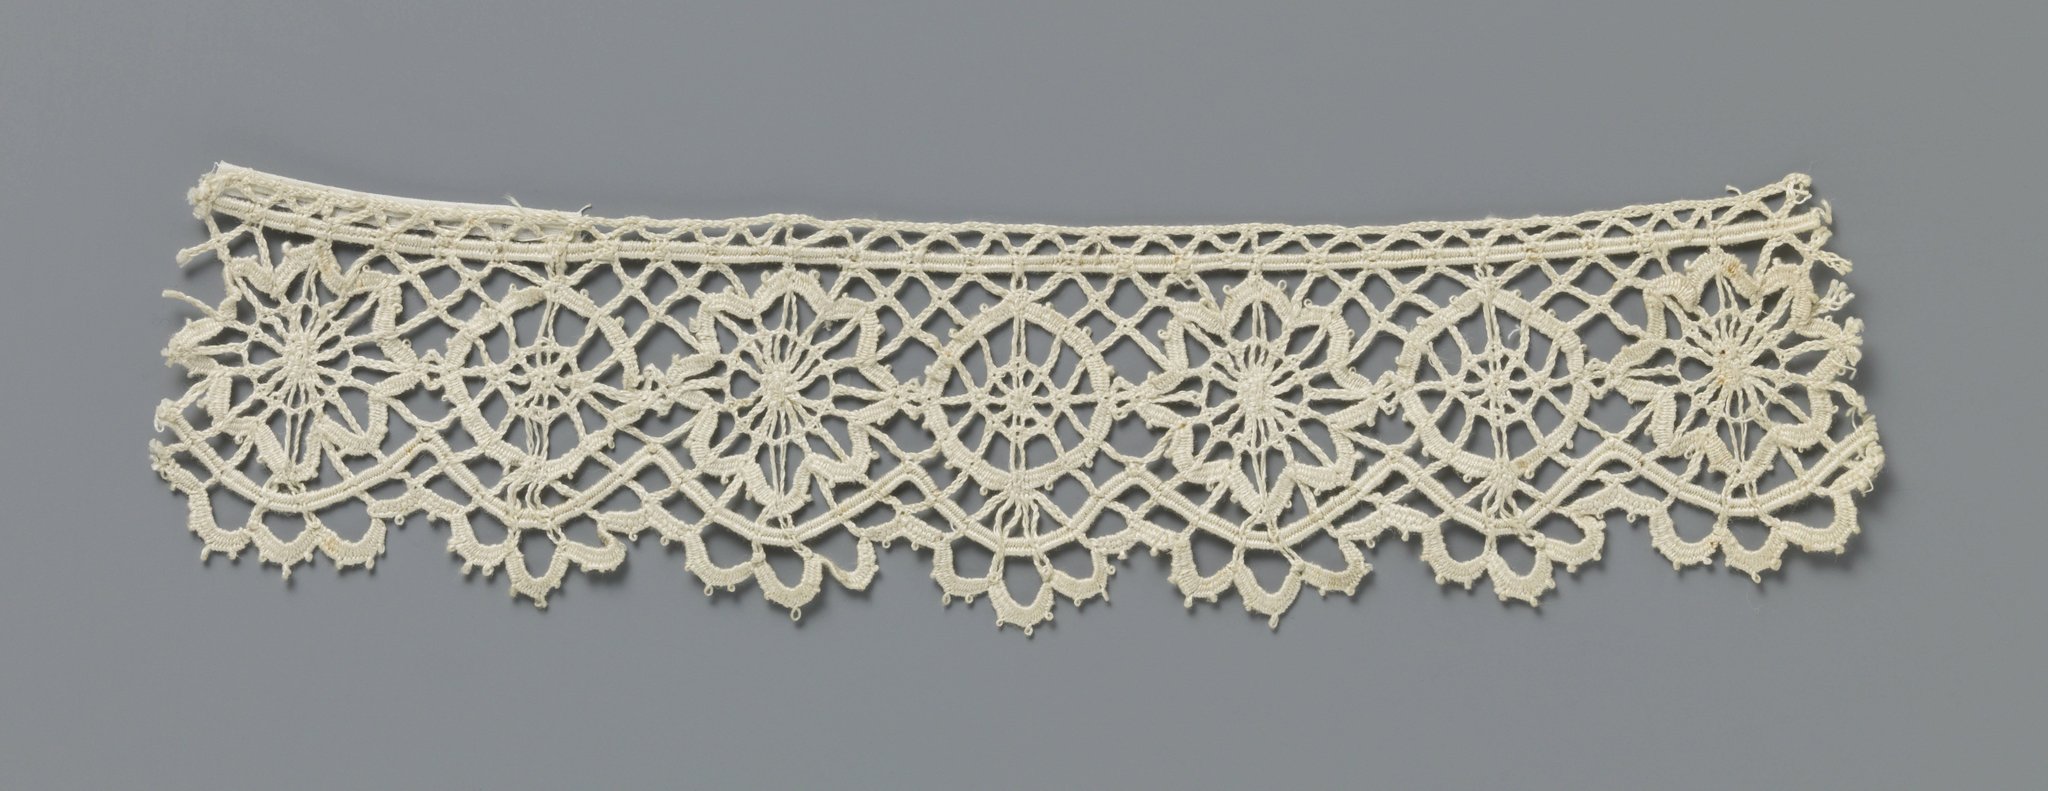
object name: strip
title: Strook kloskant met sterren en wielen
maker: Anonymous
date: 1800-1824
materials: cotton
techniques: lace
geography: france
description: Strook naturelkleurige kloskant. Het zich herhalende patroon bestaat afwisselend uit een wiel en een achtpuntige ster. De omtrek van de motieven bestaat uit een band gemaakt in vormslag. Binnen de omtrek zijn 'spaken' gemaakt met vlechten. Boven de wielen loopt een rechte band. Onder de wielen en sterren loopt een band die halfronde schulpen vormt, met daaraan vijf lobben gevormd door boogjes. Banden en boogjes zijn beide gemaakt in vormslag. De motieven zijn met elkaar verbonden door een vlechtengrond, die grove ruitvormige mazen vormt, zoals bij een Valenciennes-grond. De bovenzijde van de strook is recht afgewerkt met een zigzaggende vlecht. De boogjes aan de schulpen zijn afgewerkt met enkele picots.